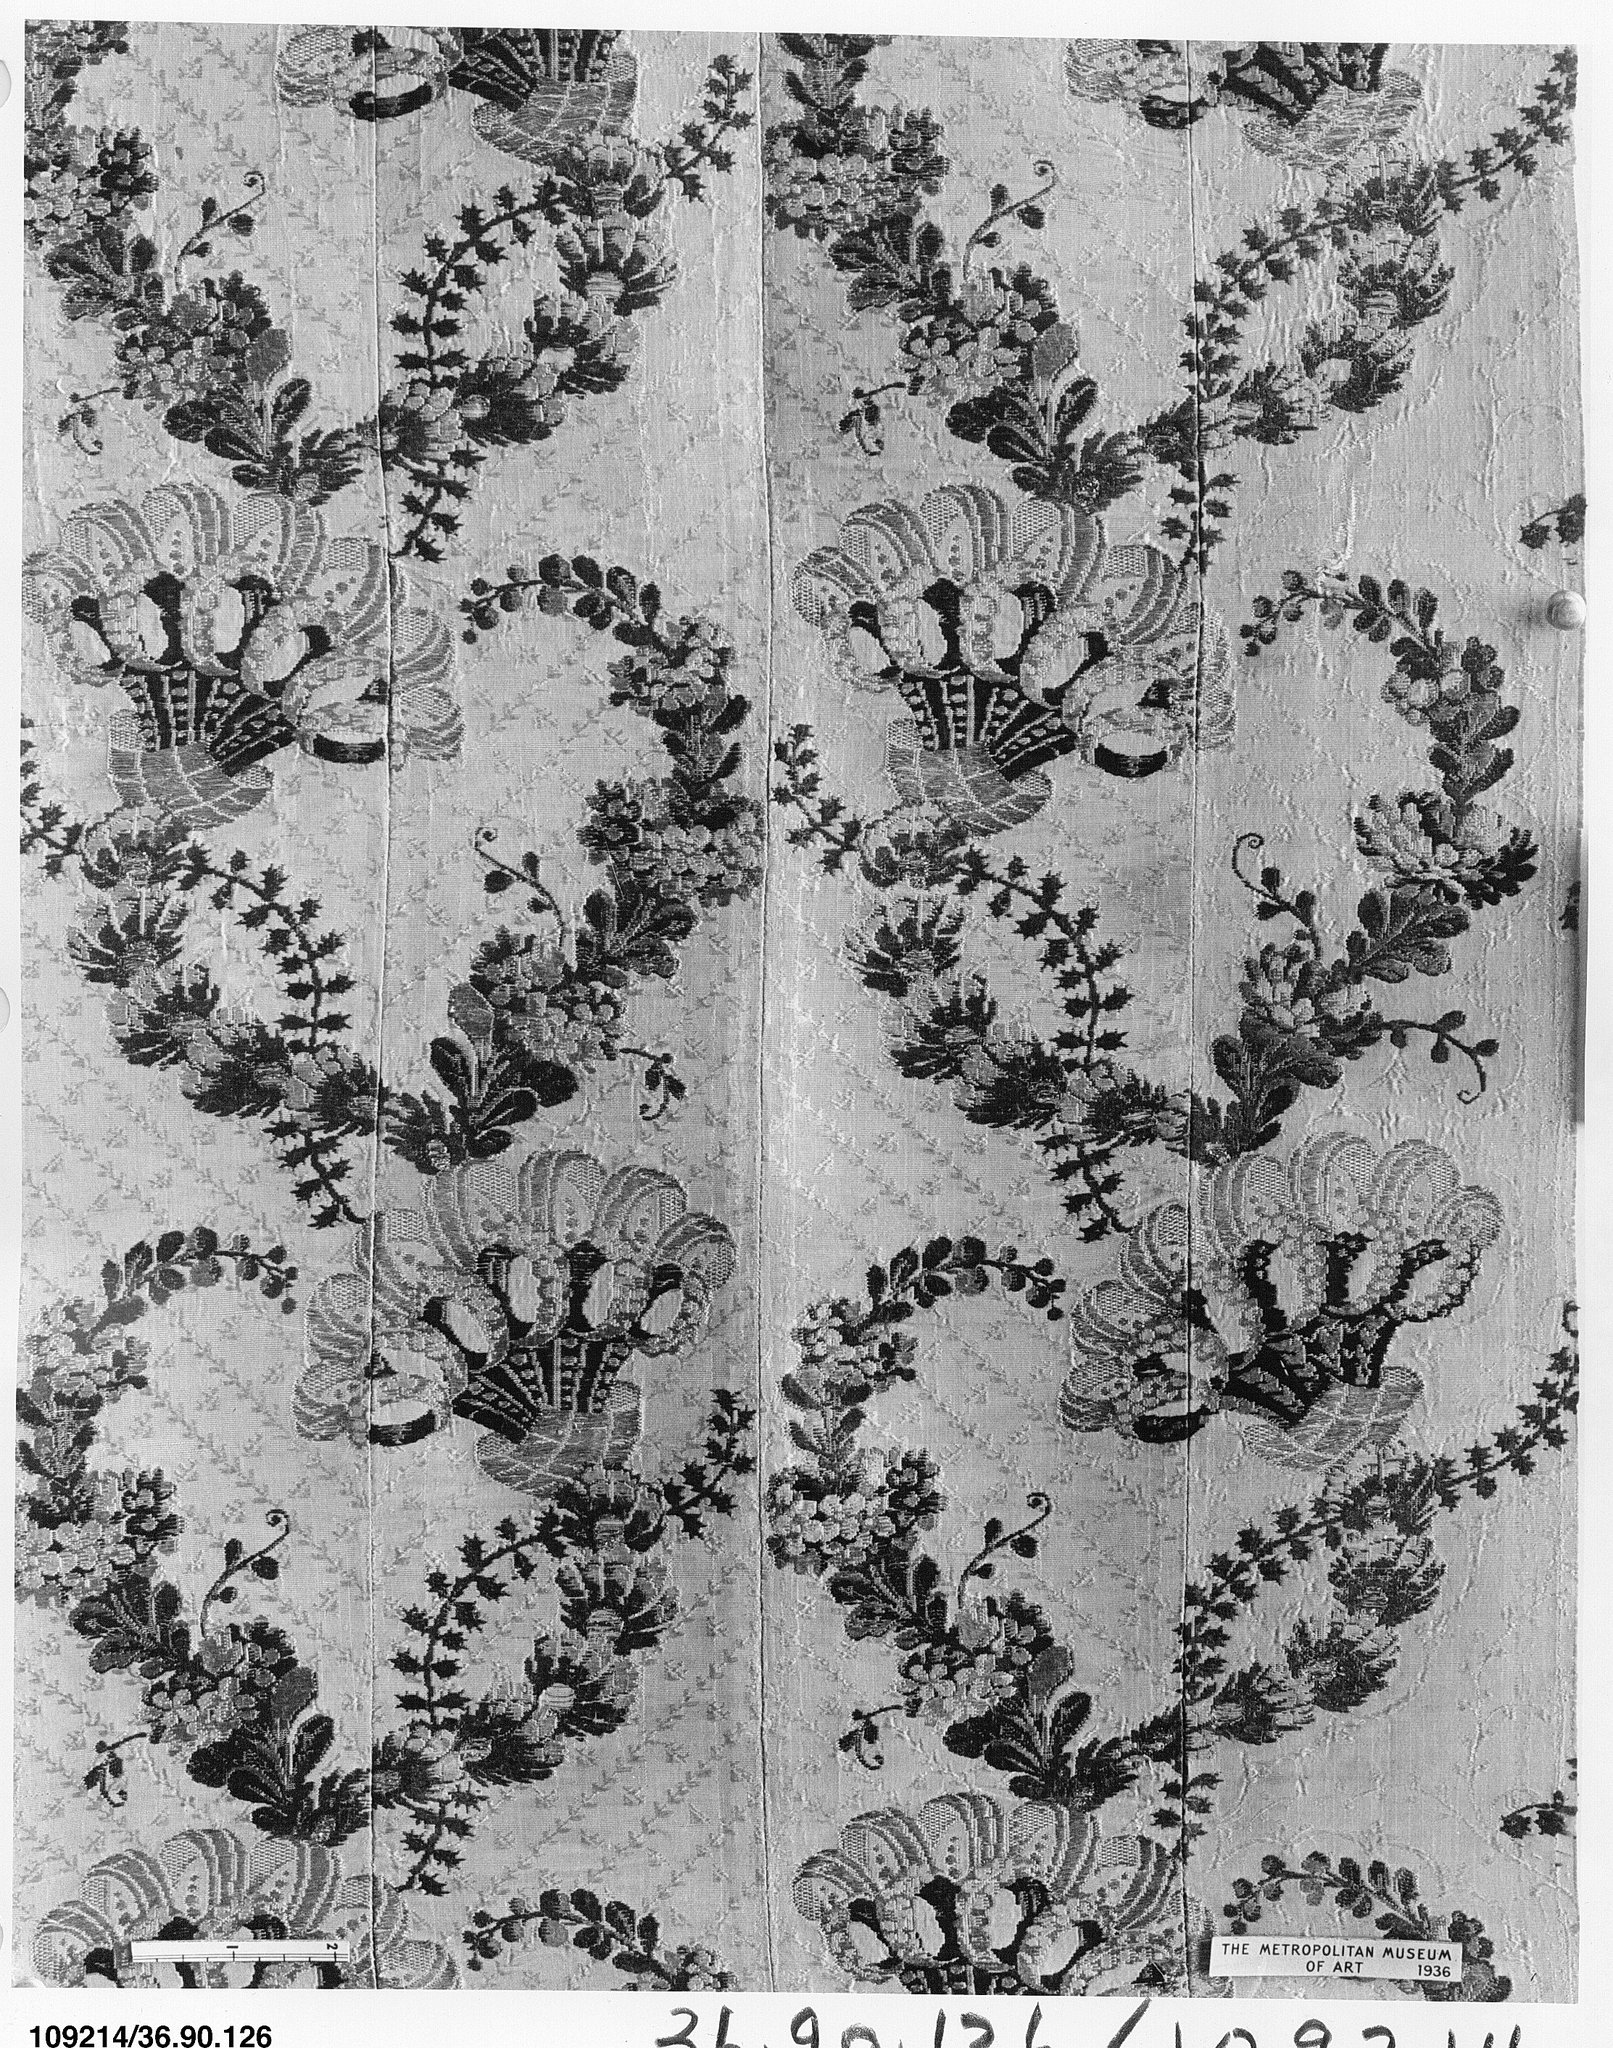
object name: piece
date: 1750-1760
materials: metal thread, silk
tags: flowers,leaves